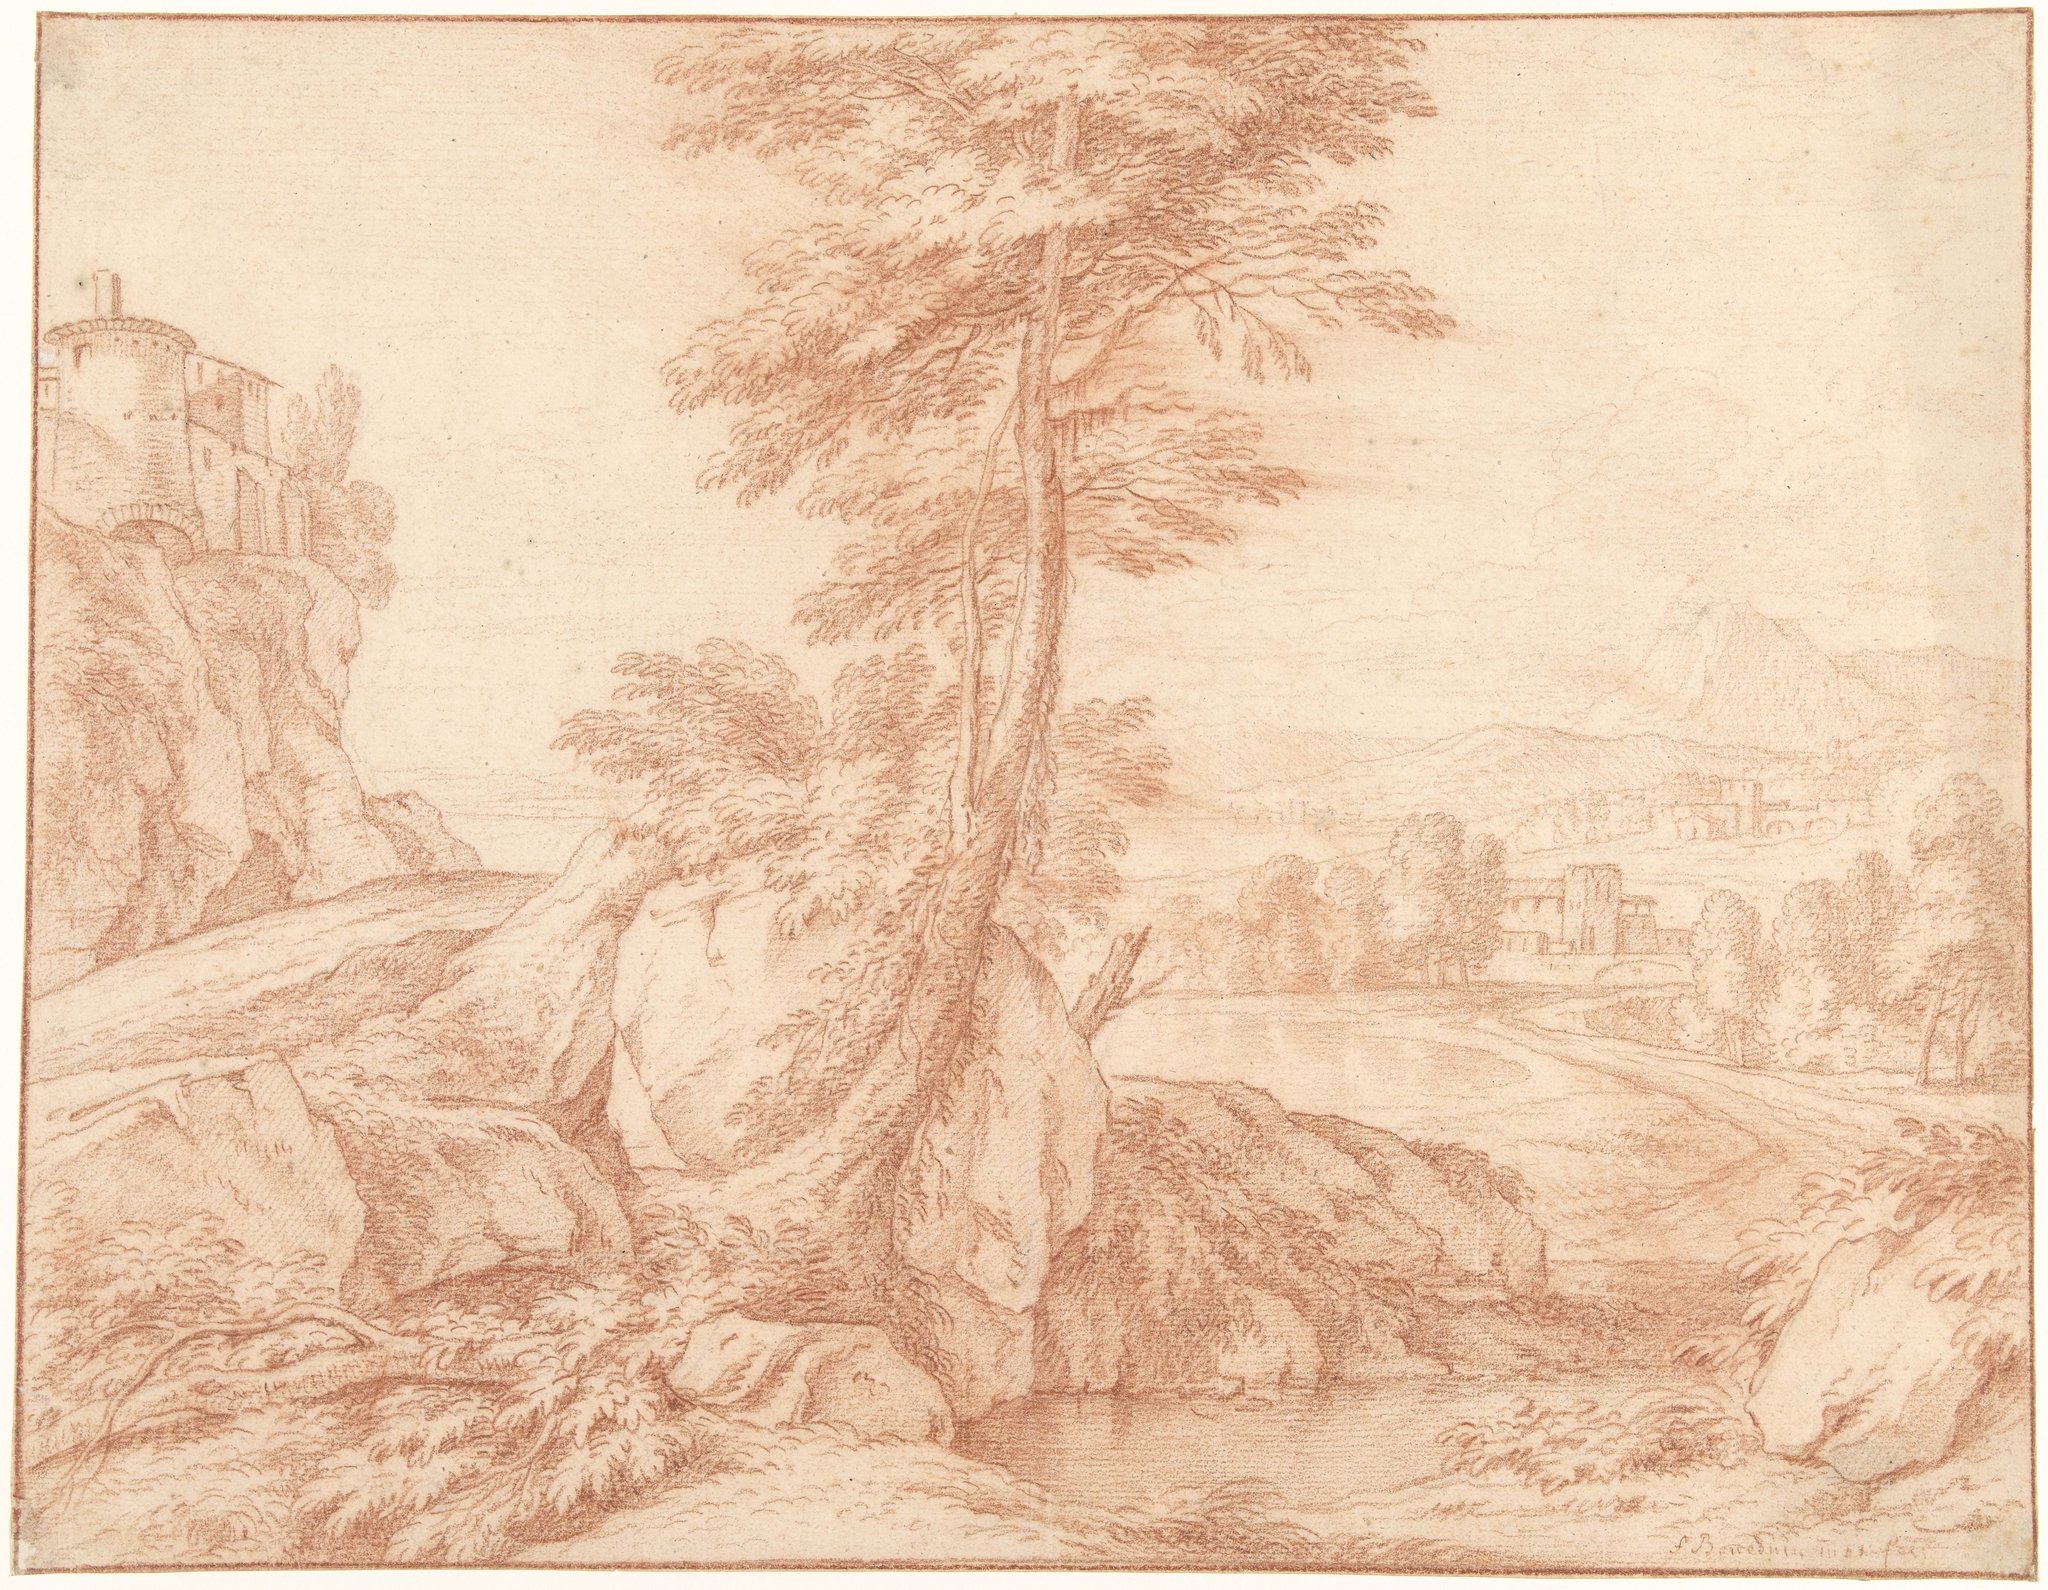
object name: drawing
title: Italiaans landschap met een boom bij een rots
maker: frans boudewijns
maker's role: draughtsman, painter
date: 1700-1766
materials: chalk, paper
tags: farm or solitary house in landscape